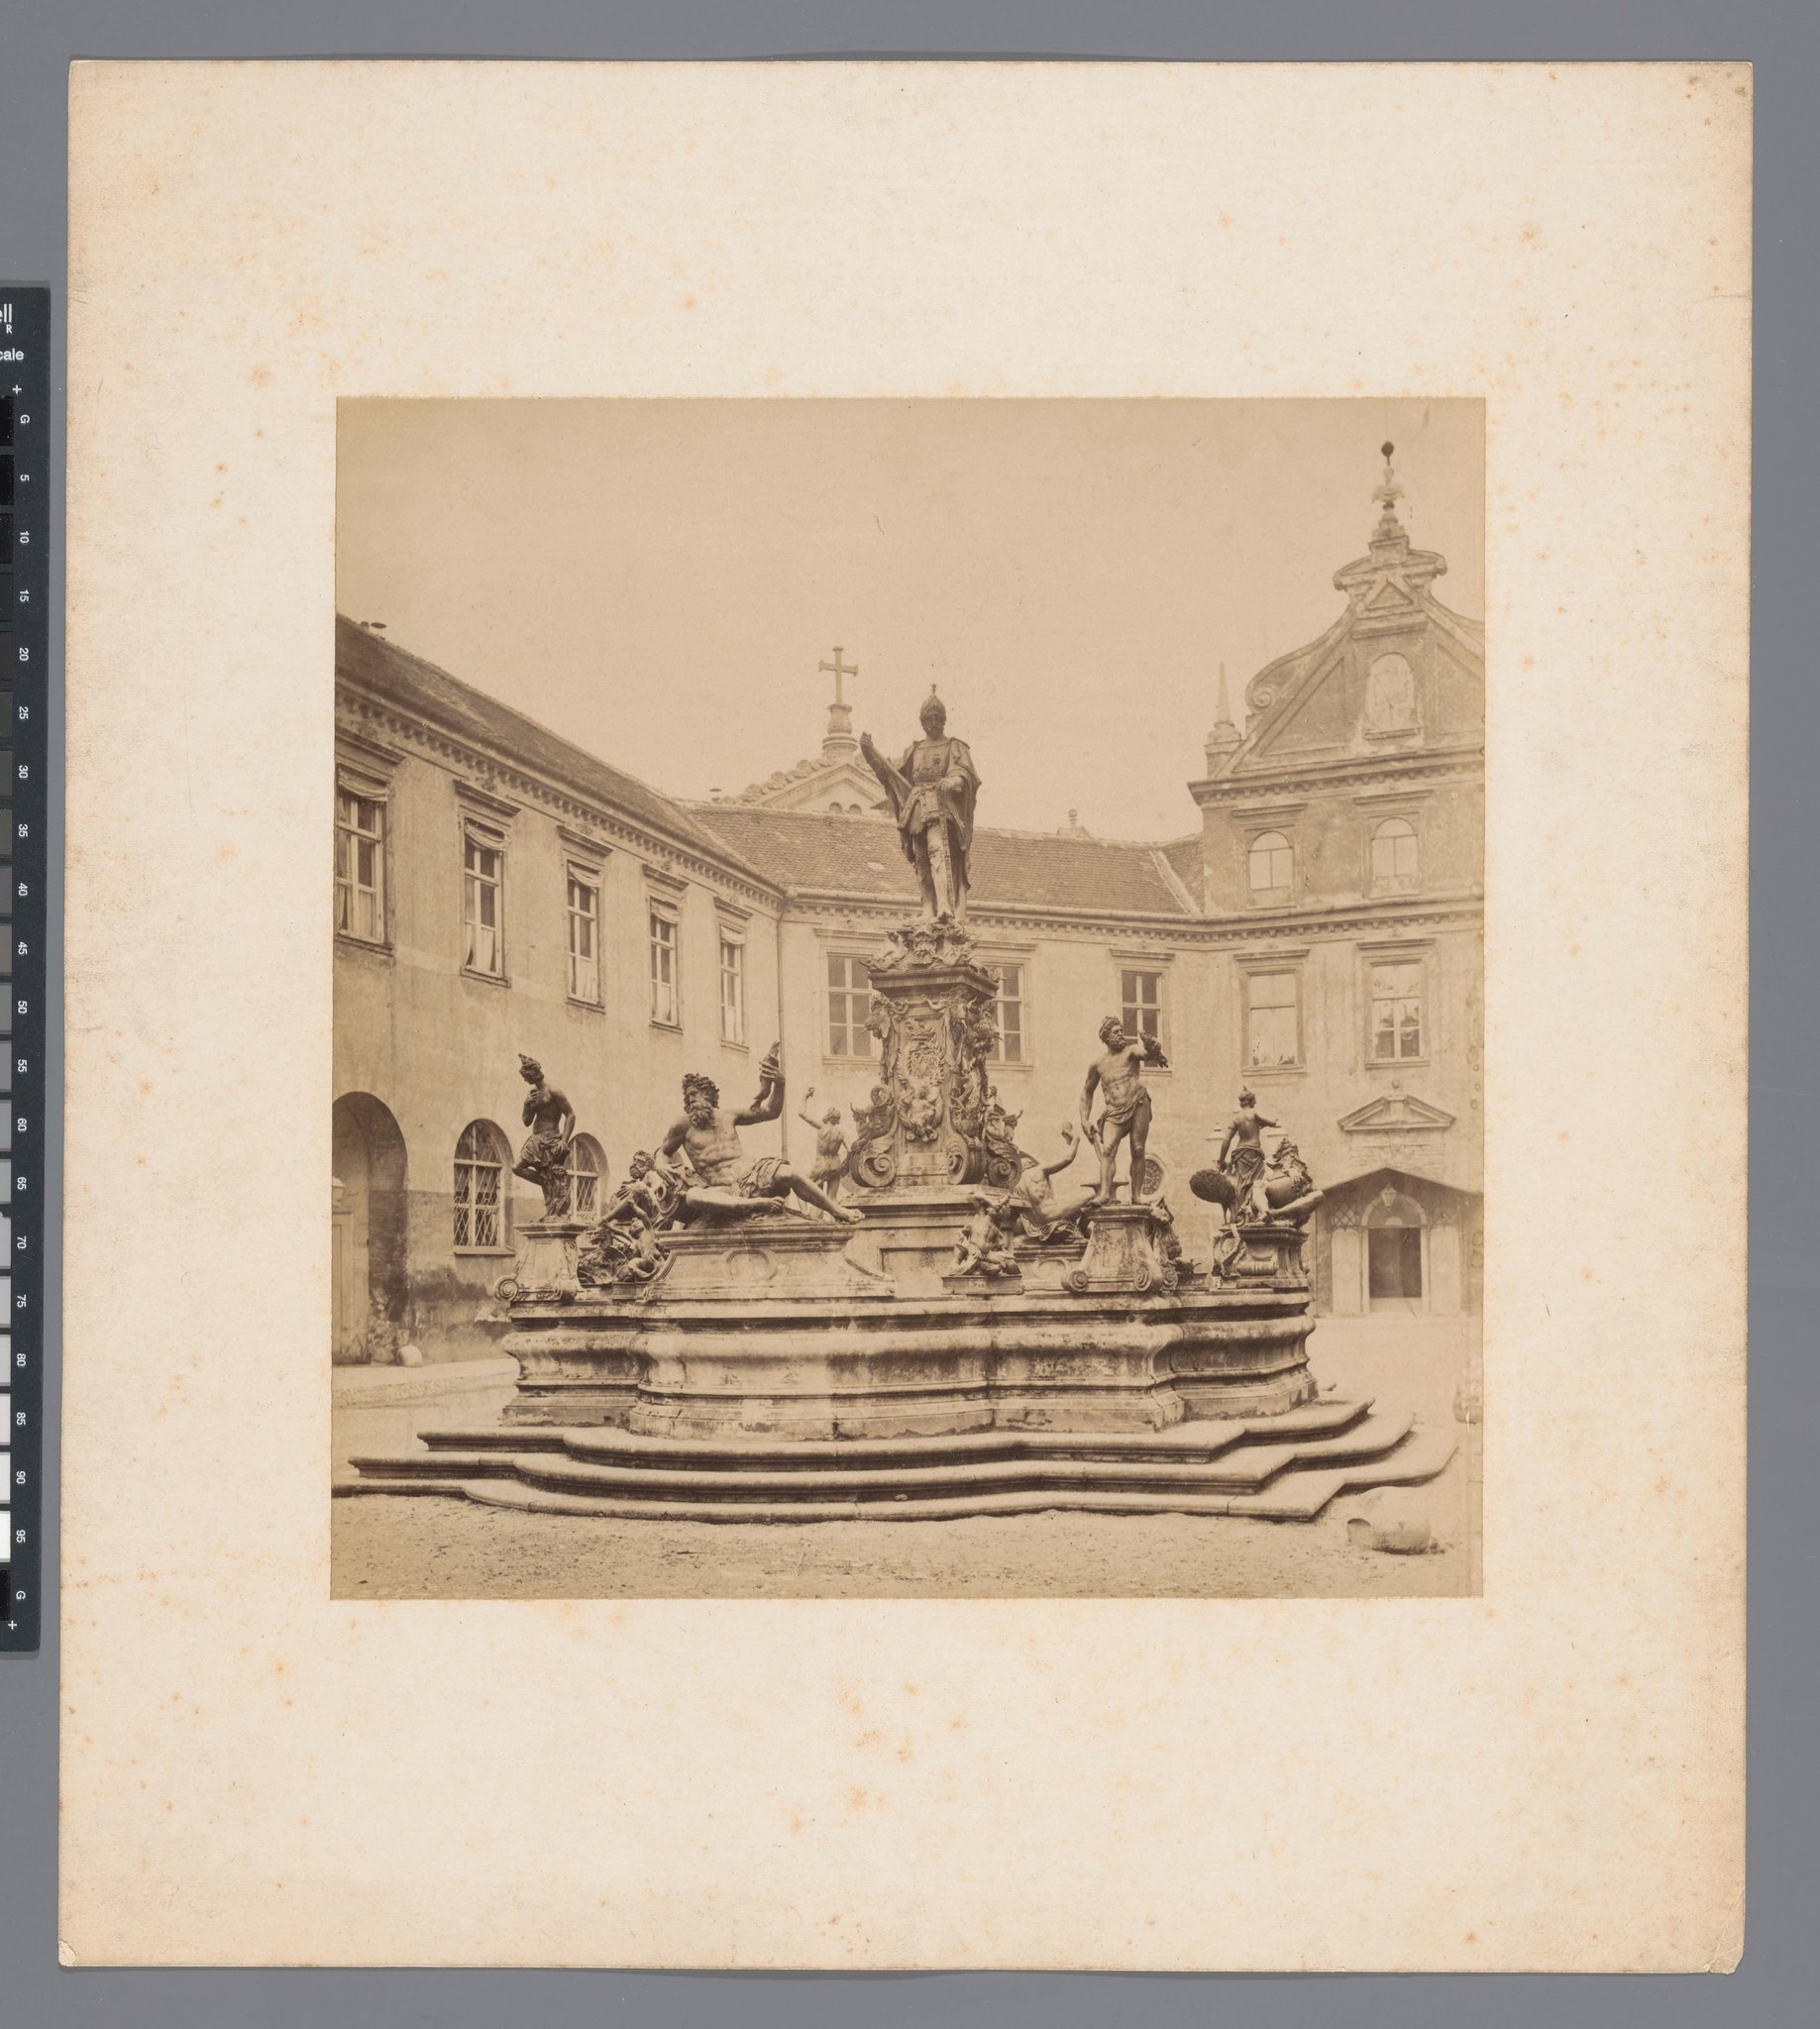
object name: photograph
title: Wittelsbacherbrunnen op het Brunnenhof in München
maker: Anonymous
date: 1883-1900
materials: cardboard, paper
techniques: albumen print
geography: munich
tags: ornamental fountain, inner court of palace or 'hôtel'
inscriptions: inscription: ‘Woensdag 23 Juli/ Perseus brunnen/ Binnenplaats/ Alte Residenz München/ 3’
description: Deze foto maakt deel uit van een fotoserie, gemaakt of gekocht door een Nederlandse reiziger die onderweg was in Duitsland, Oostenrijk en Italië tussen 27 juni en 29 juli. Het jaartal van de reis is onbekend, maar de foto's zijn waarschijnlijk gemaakt tussen 1883 en 1900.